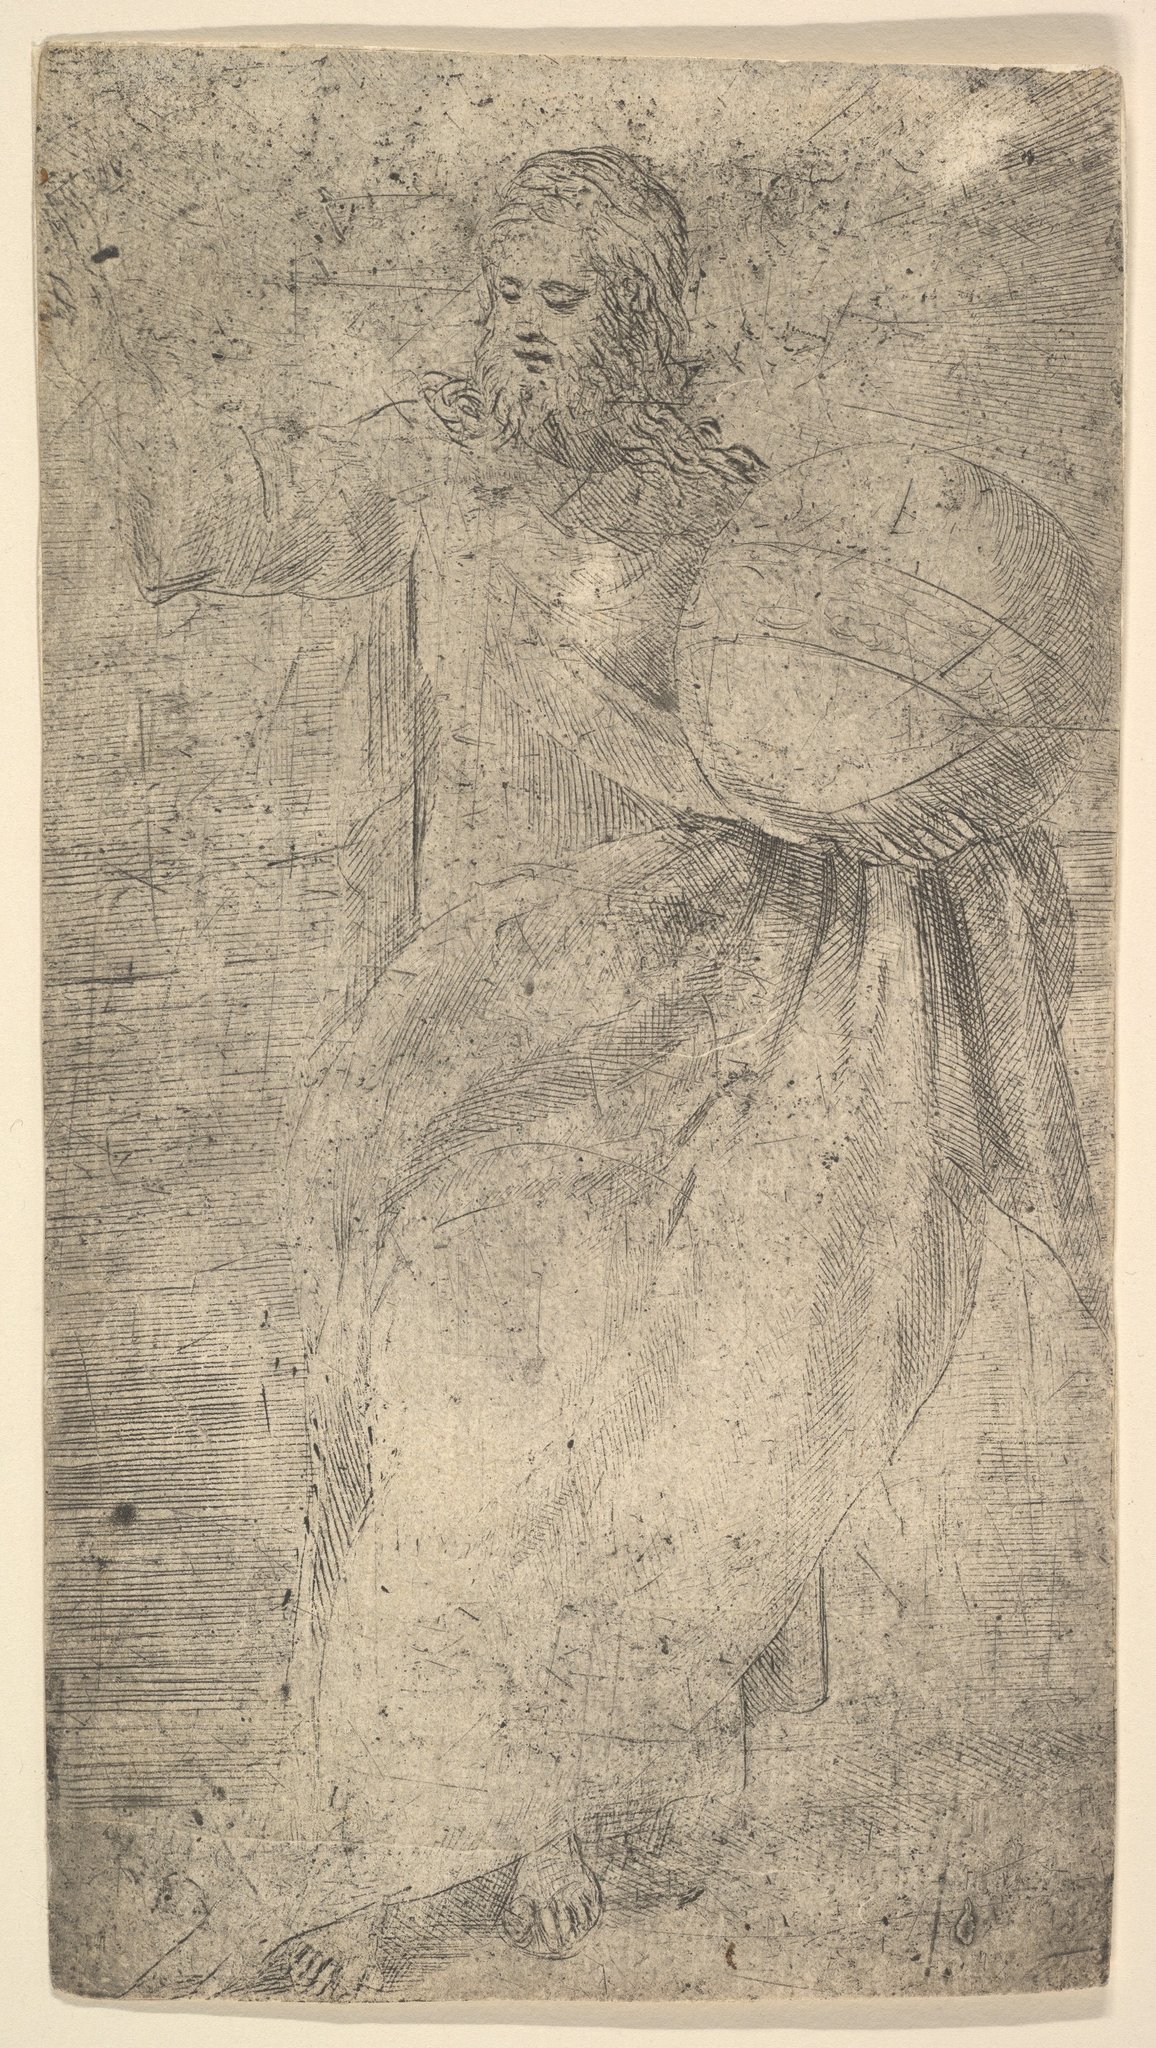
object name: print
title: Christ as the Savior holding a globe, from "Christ and the Apostles"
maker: andrea schiavone (andrea meldola)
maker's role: artist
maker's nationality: italian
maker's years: 1510-1563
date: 1548-1550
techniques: etching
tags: christ,globes